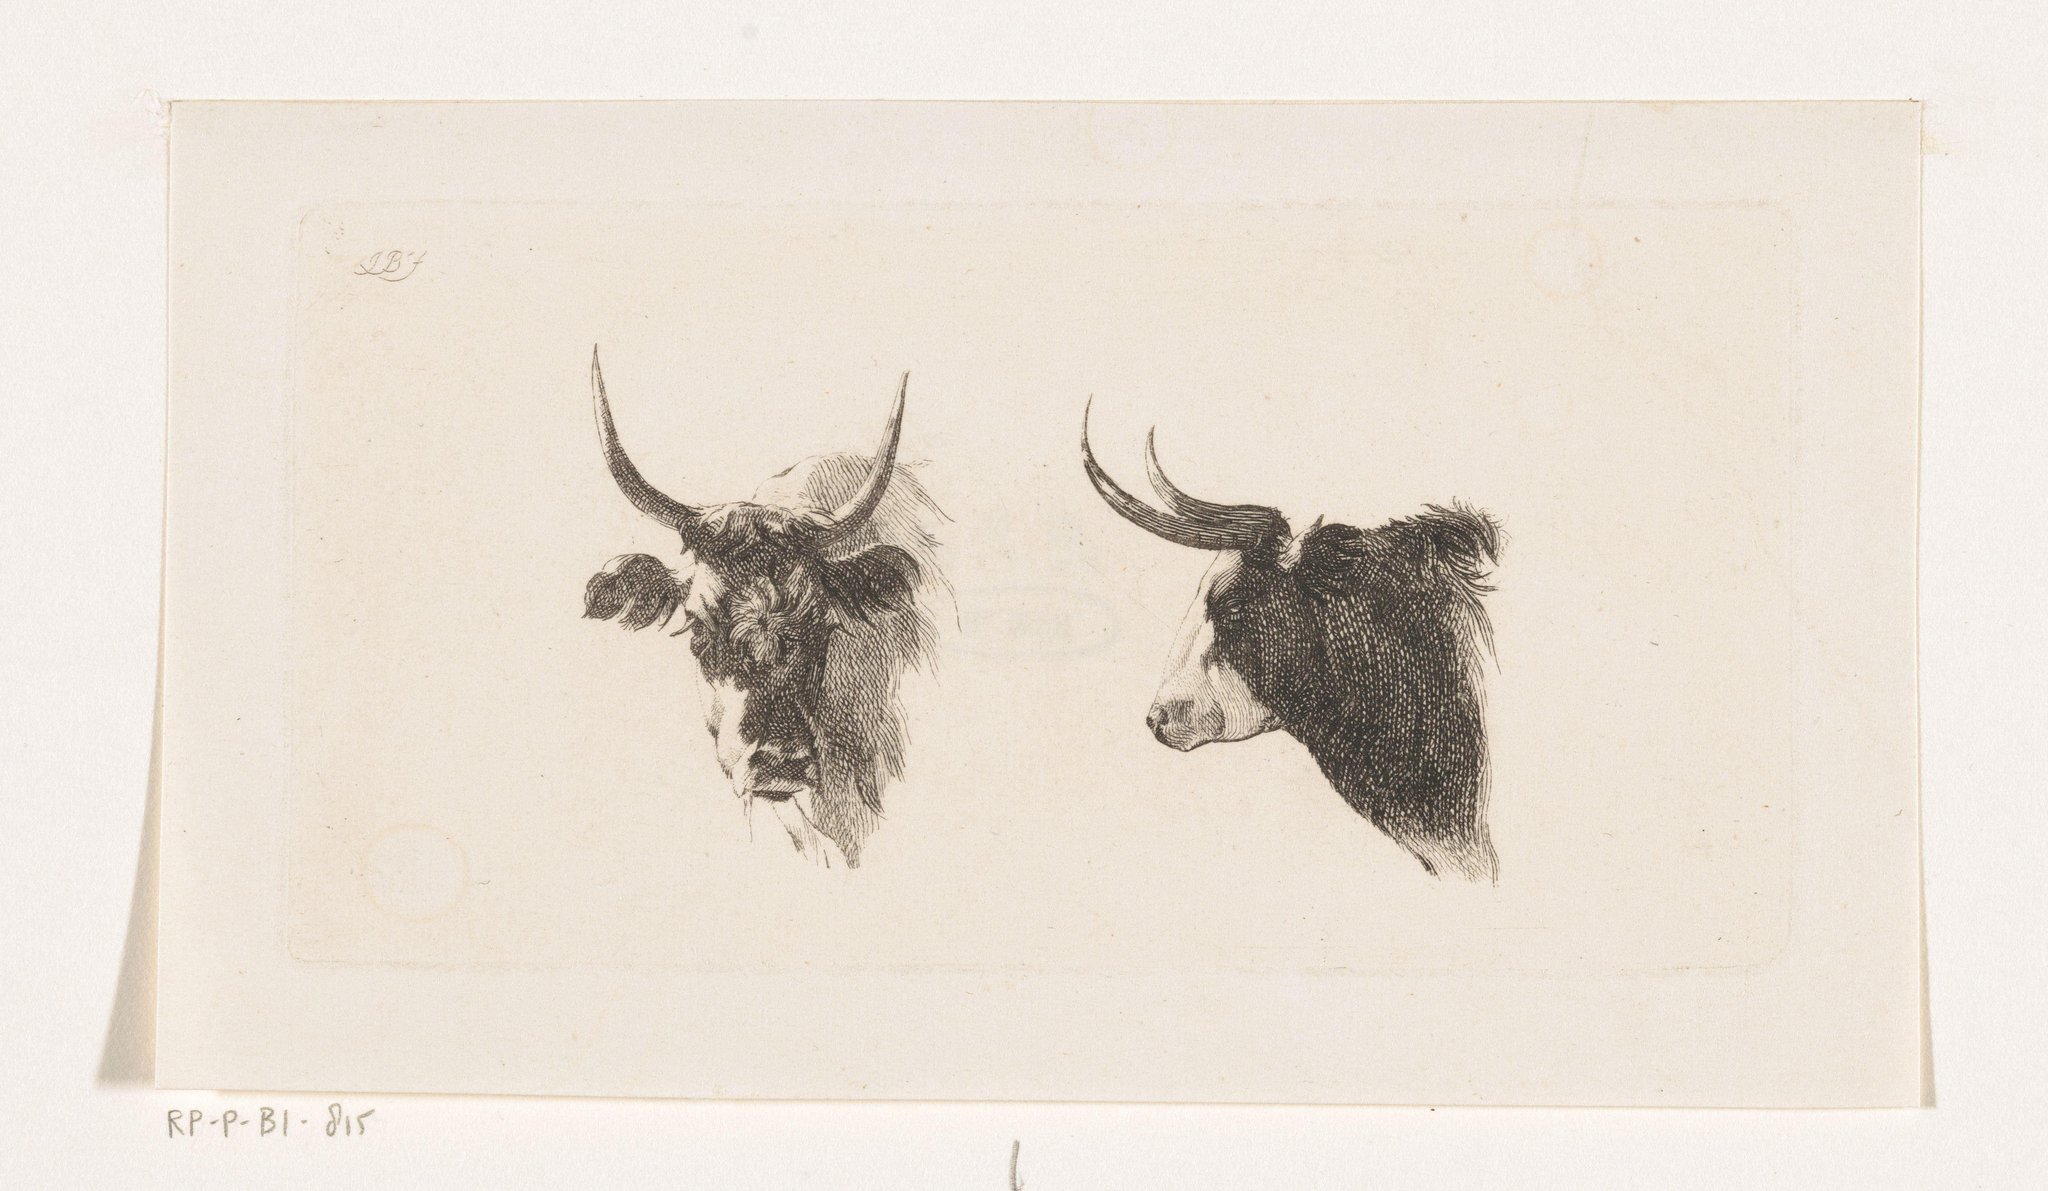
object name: print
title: Twee koeienkoppen, de een en face de ander in zijaansicht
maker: joannes bemme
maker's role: print maker, printer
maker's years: 1775-1841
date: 1800-1841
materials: paper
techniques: etching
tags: cow (+ head of an animal)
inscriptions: collector's mark: Lugt 2228